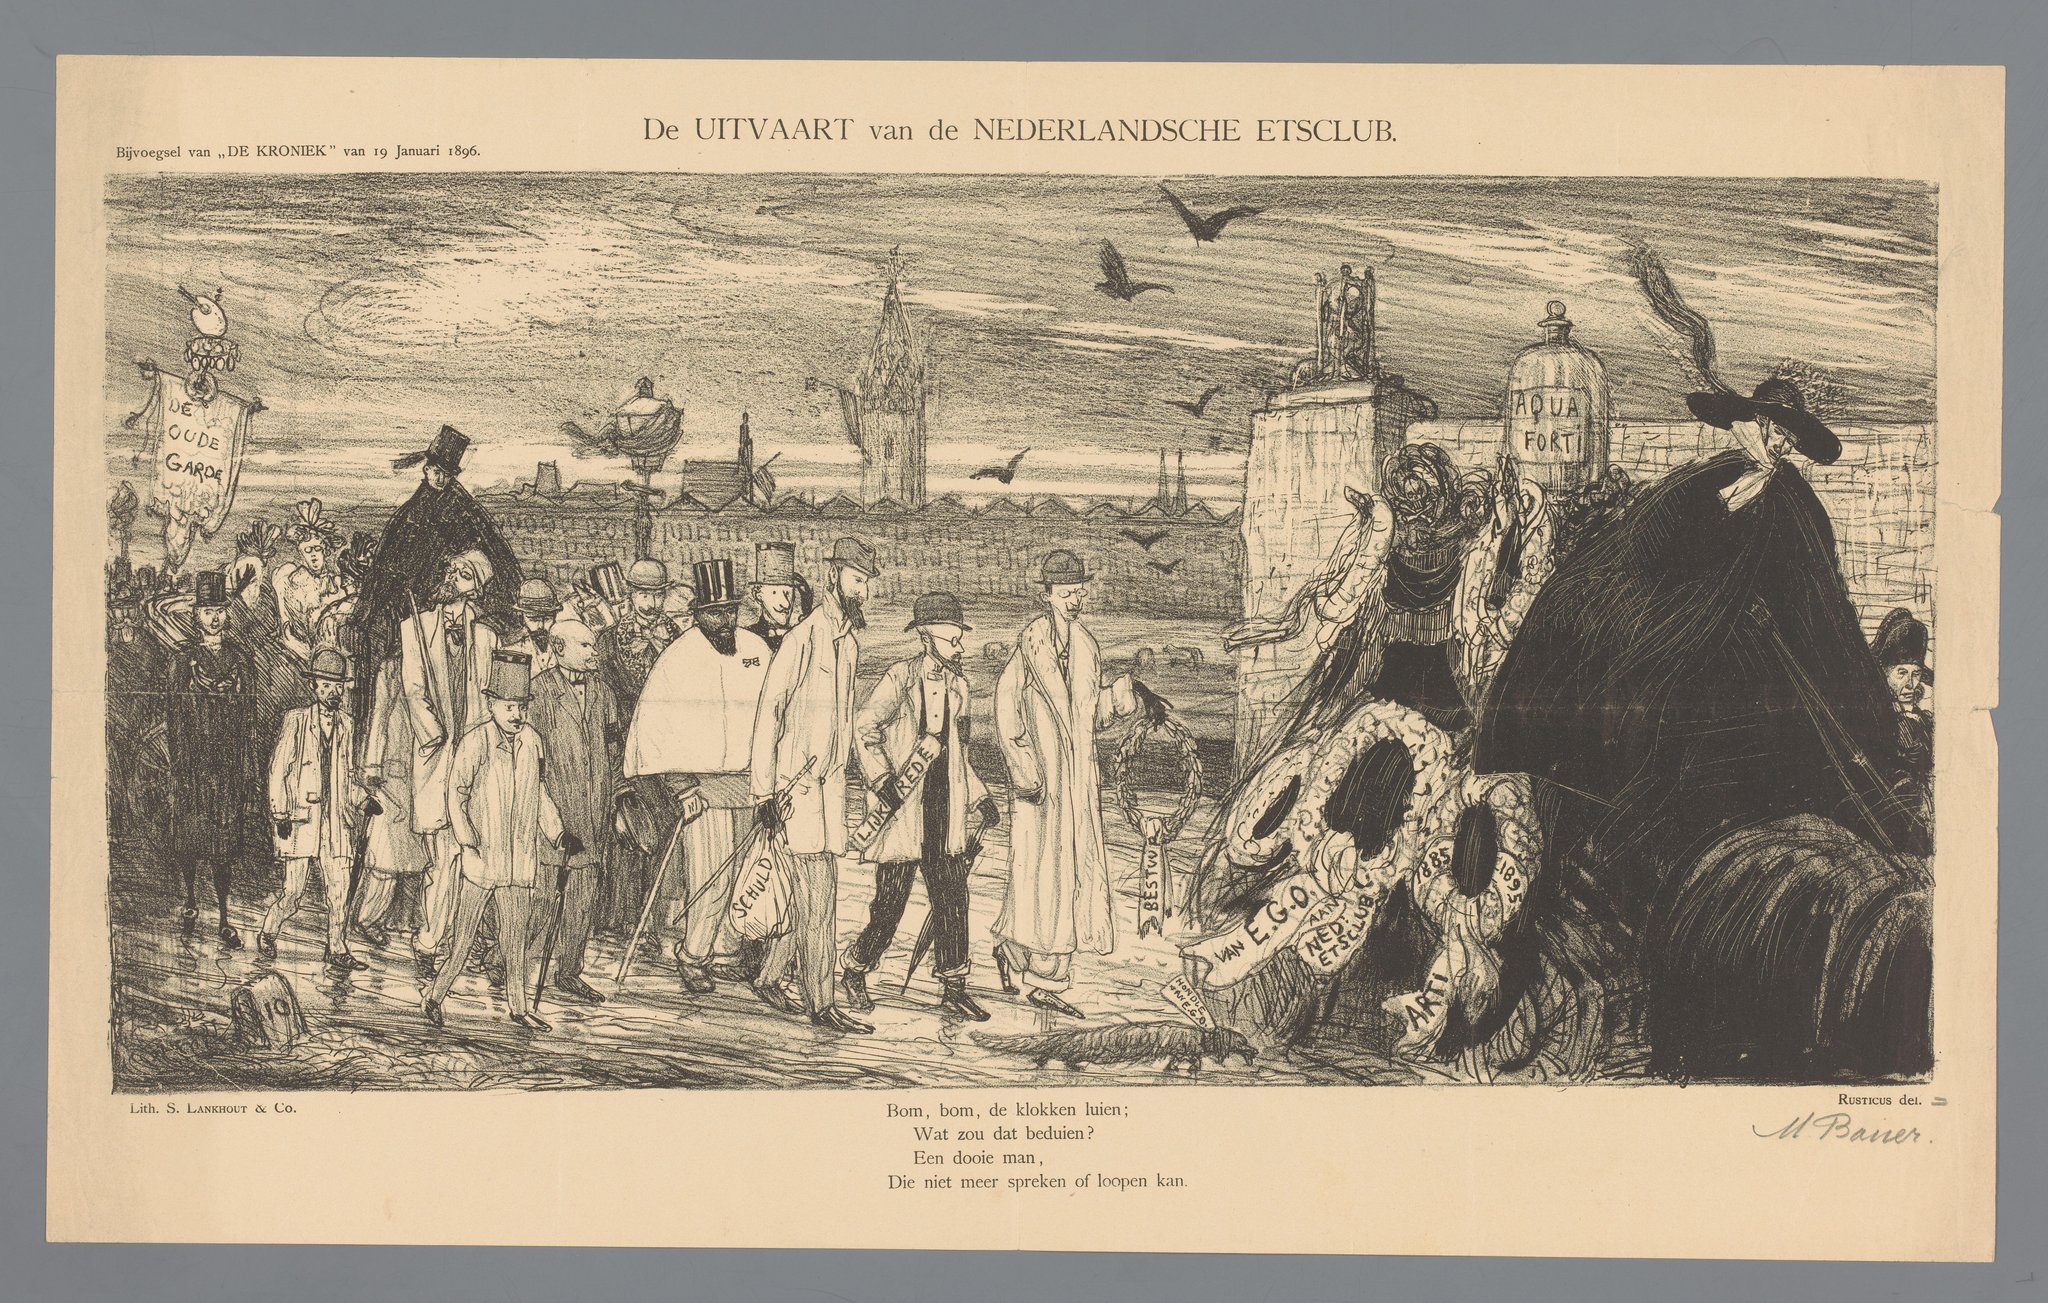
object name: cartoon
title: De Uitvaart van de Nederlandsche Etsclub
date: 1896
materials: paper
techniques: lithograph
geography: netherlands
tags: thérèse schwartze, designer, jan veth, marinus van der maarel, maurits van der valk, etienne bosch, anton l. koster, marius bauer, wally moes, amsterdam, the hague, print maker, draughtsman, hendrik johannes haverman, utrecht, etha fles, jan toorop, painter, philip zilcken, cortege, funeral procession, graphic artist, political caricatures and satires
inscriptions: date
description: Spotprent waarin de Nederlandsche Etsclub ten grave wordt gedragen. De Etsclub hief zichzelf op op 13 januari 1896. Vooraan in de stoet de lijkwagen met rouwkransen 1885-1895, daarachter lopen de leden: Jan Veth (met bord 'lijkrede'), Philip Zilcken, Maurits van der Valk, Marinus van der Maarel, Etienne Bosch, Anton L. Koster, Hendrik J. Haverman en Jan Toorp. Marius Bauer heeft zichzelf als penningmeester van de Etsclub afgebeeld met de zak met het opschrift 'schuld'. Achter deze groep volgen de damesleden in een rijtuig: Etha Fles, Wally Moes en Thérèse Schwartze. Achteraan de stoet 'De Oude Garde'. Gepubliceerd als bijvoegsel van 'De Kroniek' van 19 januari 1896.